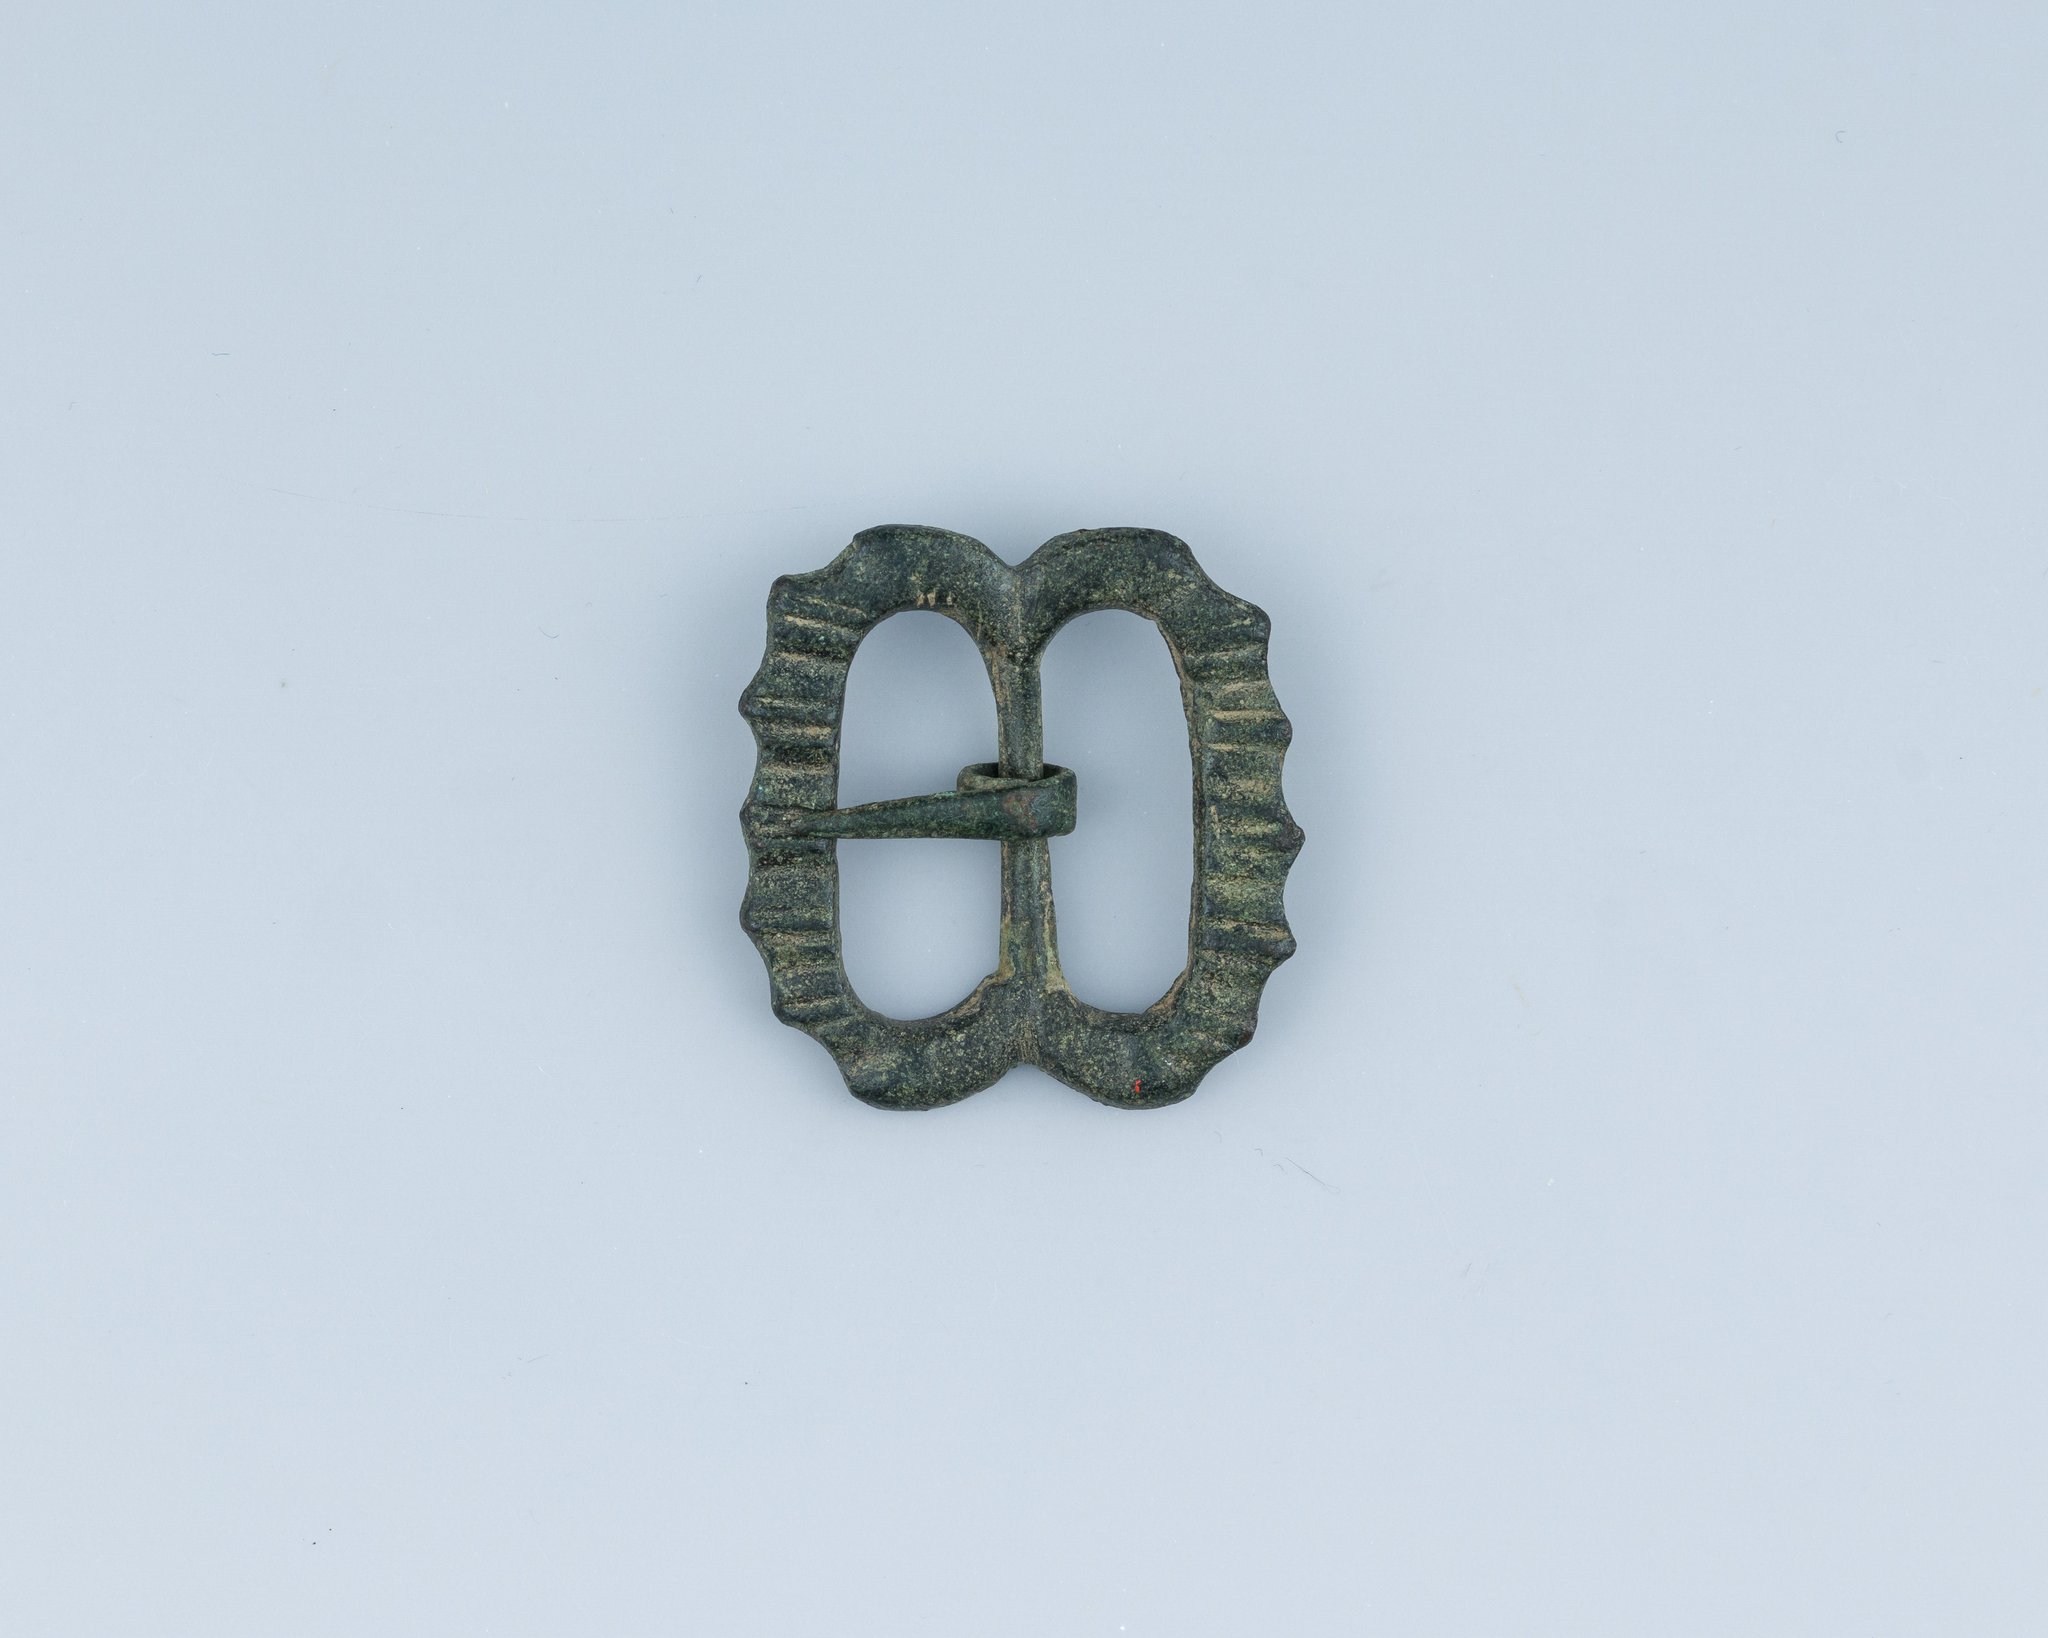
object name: buckle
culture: european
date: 1401-1600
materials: bronze